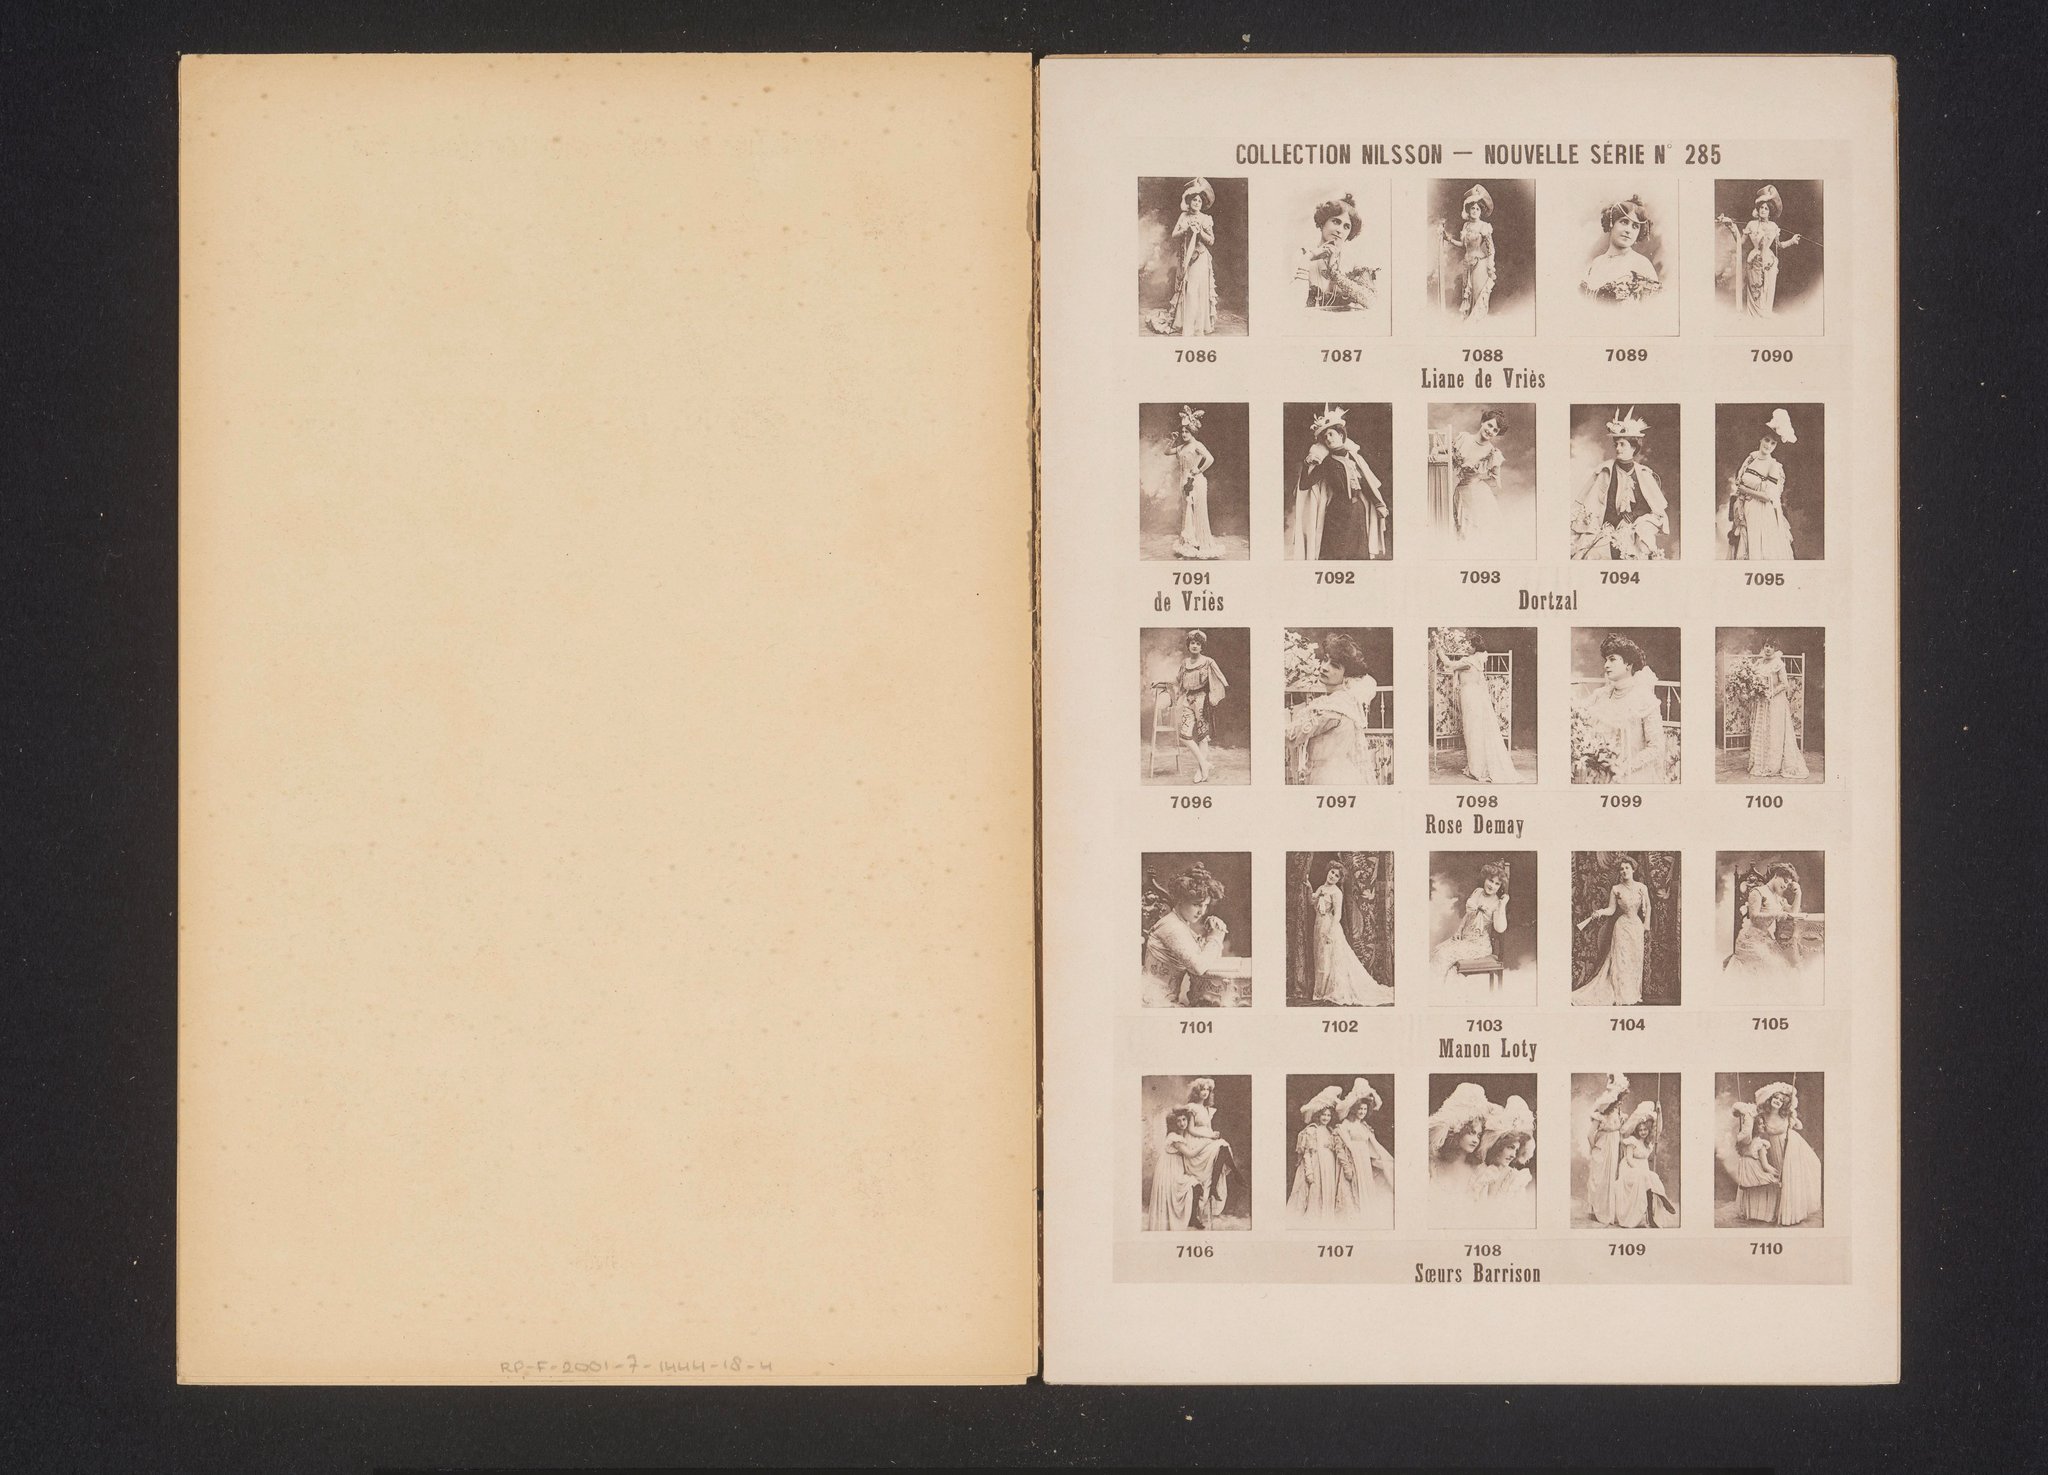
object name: page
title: 25 portretten van Liane de Vriès, Dortzal, Rose Demay, Manon Loty en de Barrison zussen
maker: Anonymous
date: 1895-1900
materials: paper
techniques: photograph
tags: historical persons - bb - woman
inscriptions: number: ‘No 285’